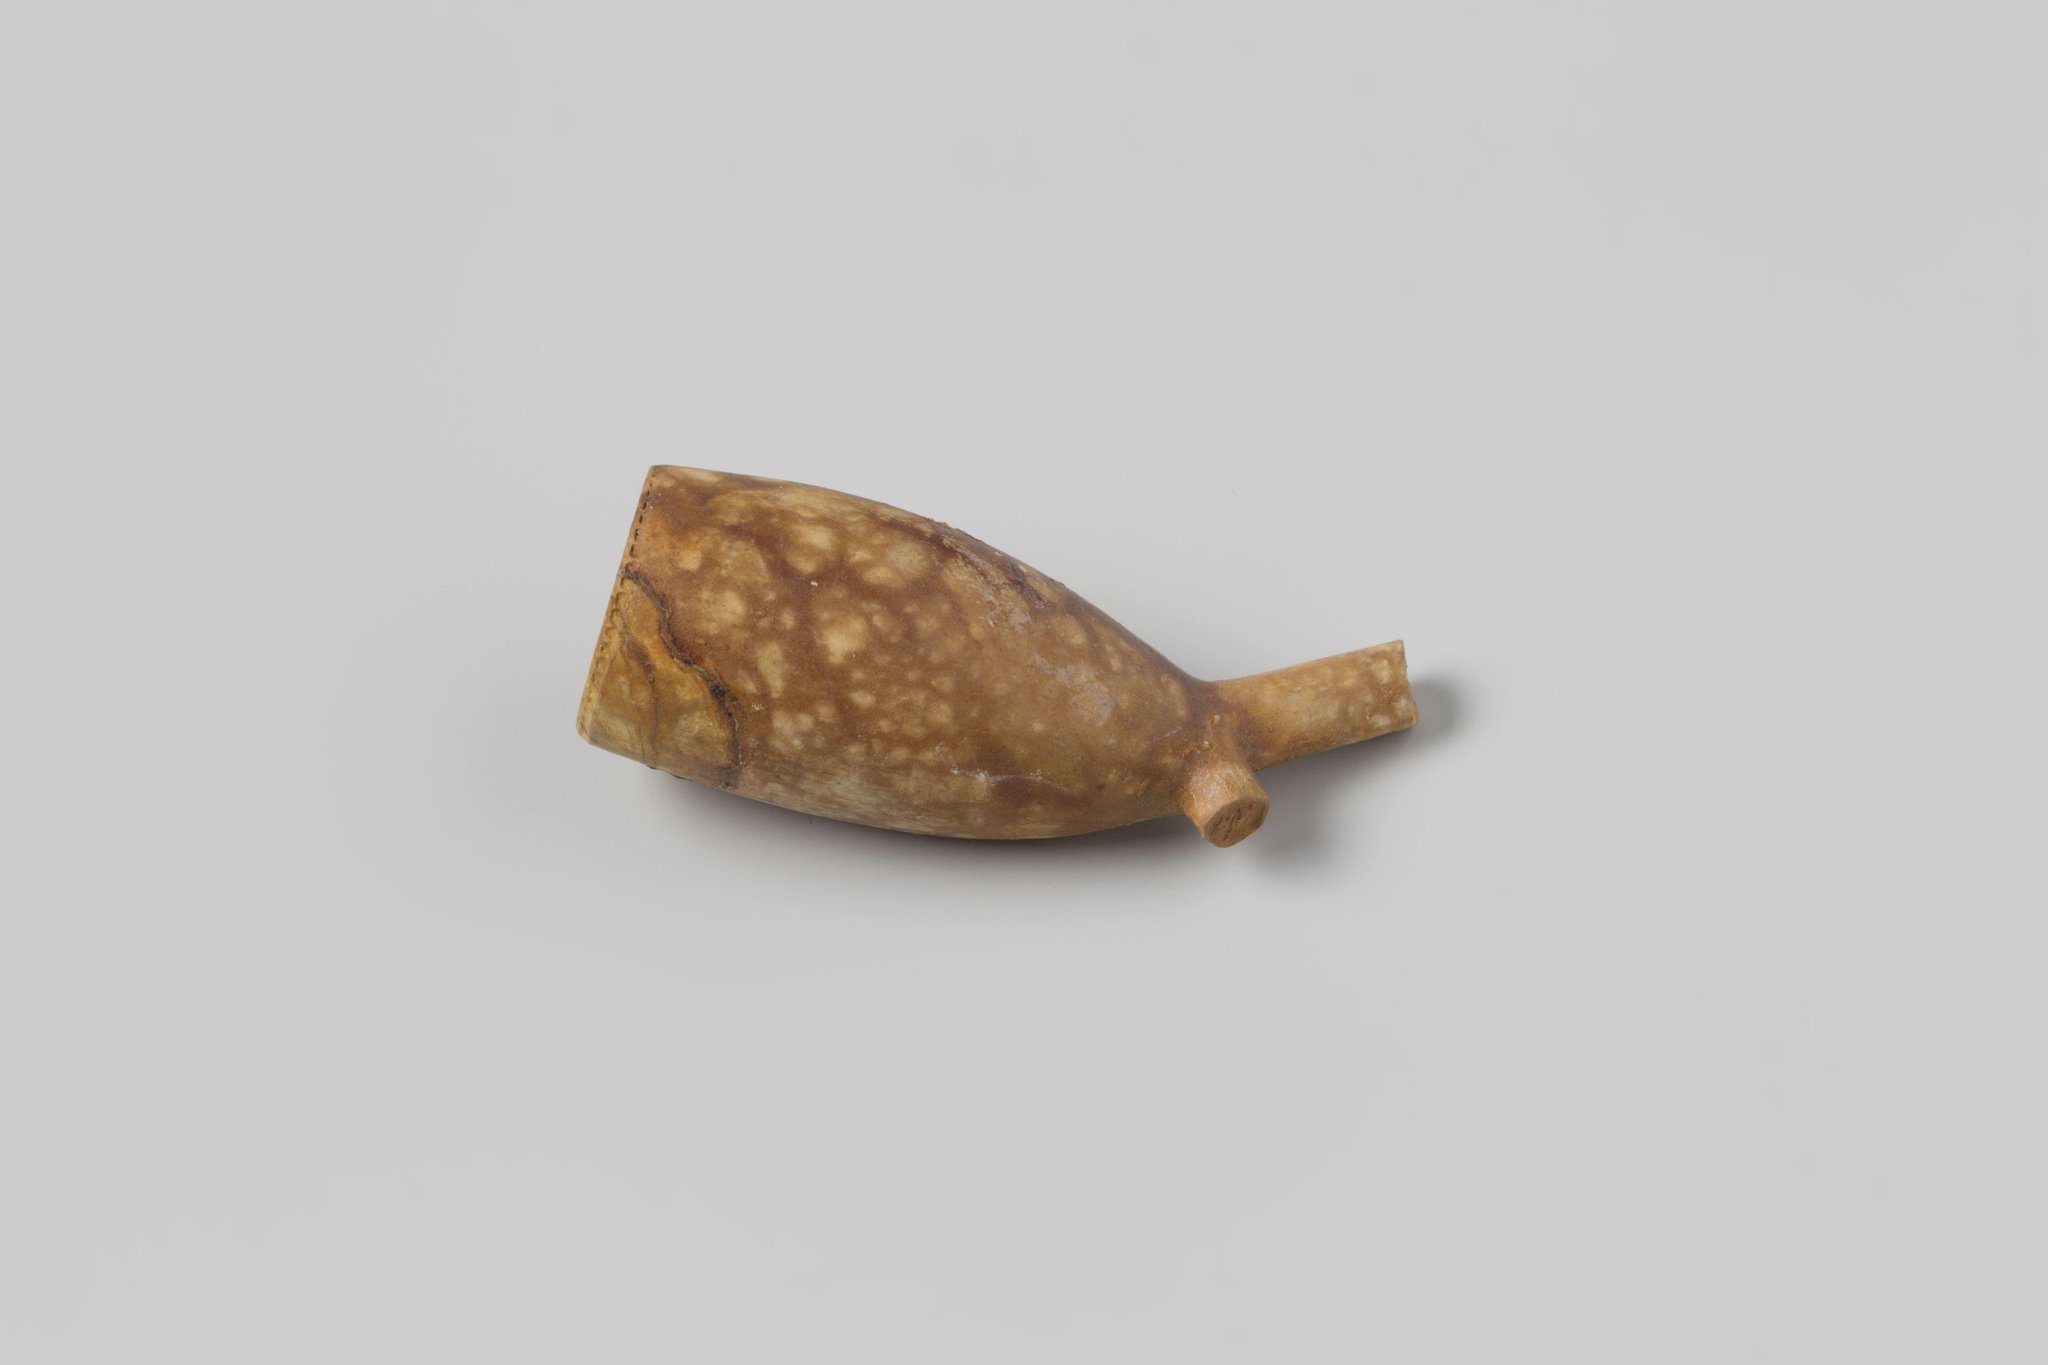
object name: pipe bowl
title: Pijpenkop uit het wrak van de Oost-Indiëvaarder Hollandia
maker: Anonymous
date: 1700-1743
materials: clay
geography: netherlands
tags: verenigde oostindische compagnie, hollandia (schip), annet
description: Pipe, bowl, heelmark: tobacco's brazier; 2hsm1,2.